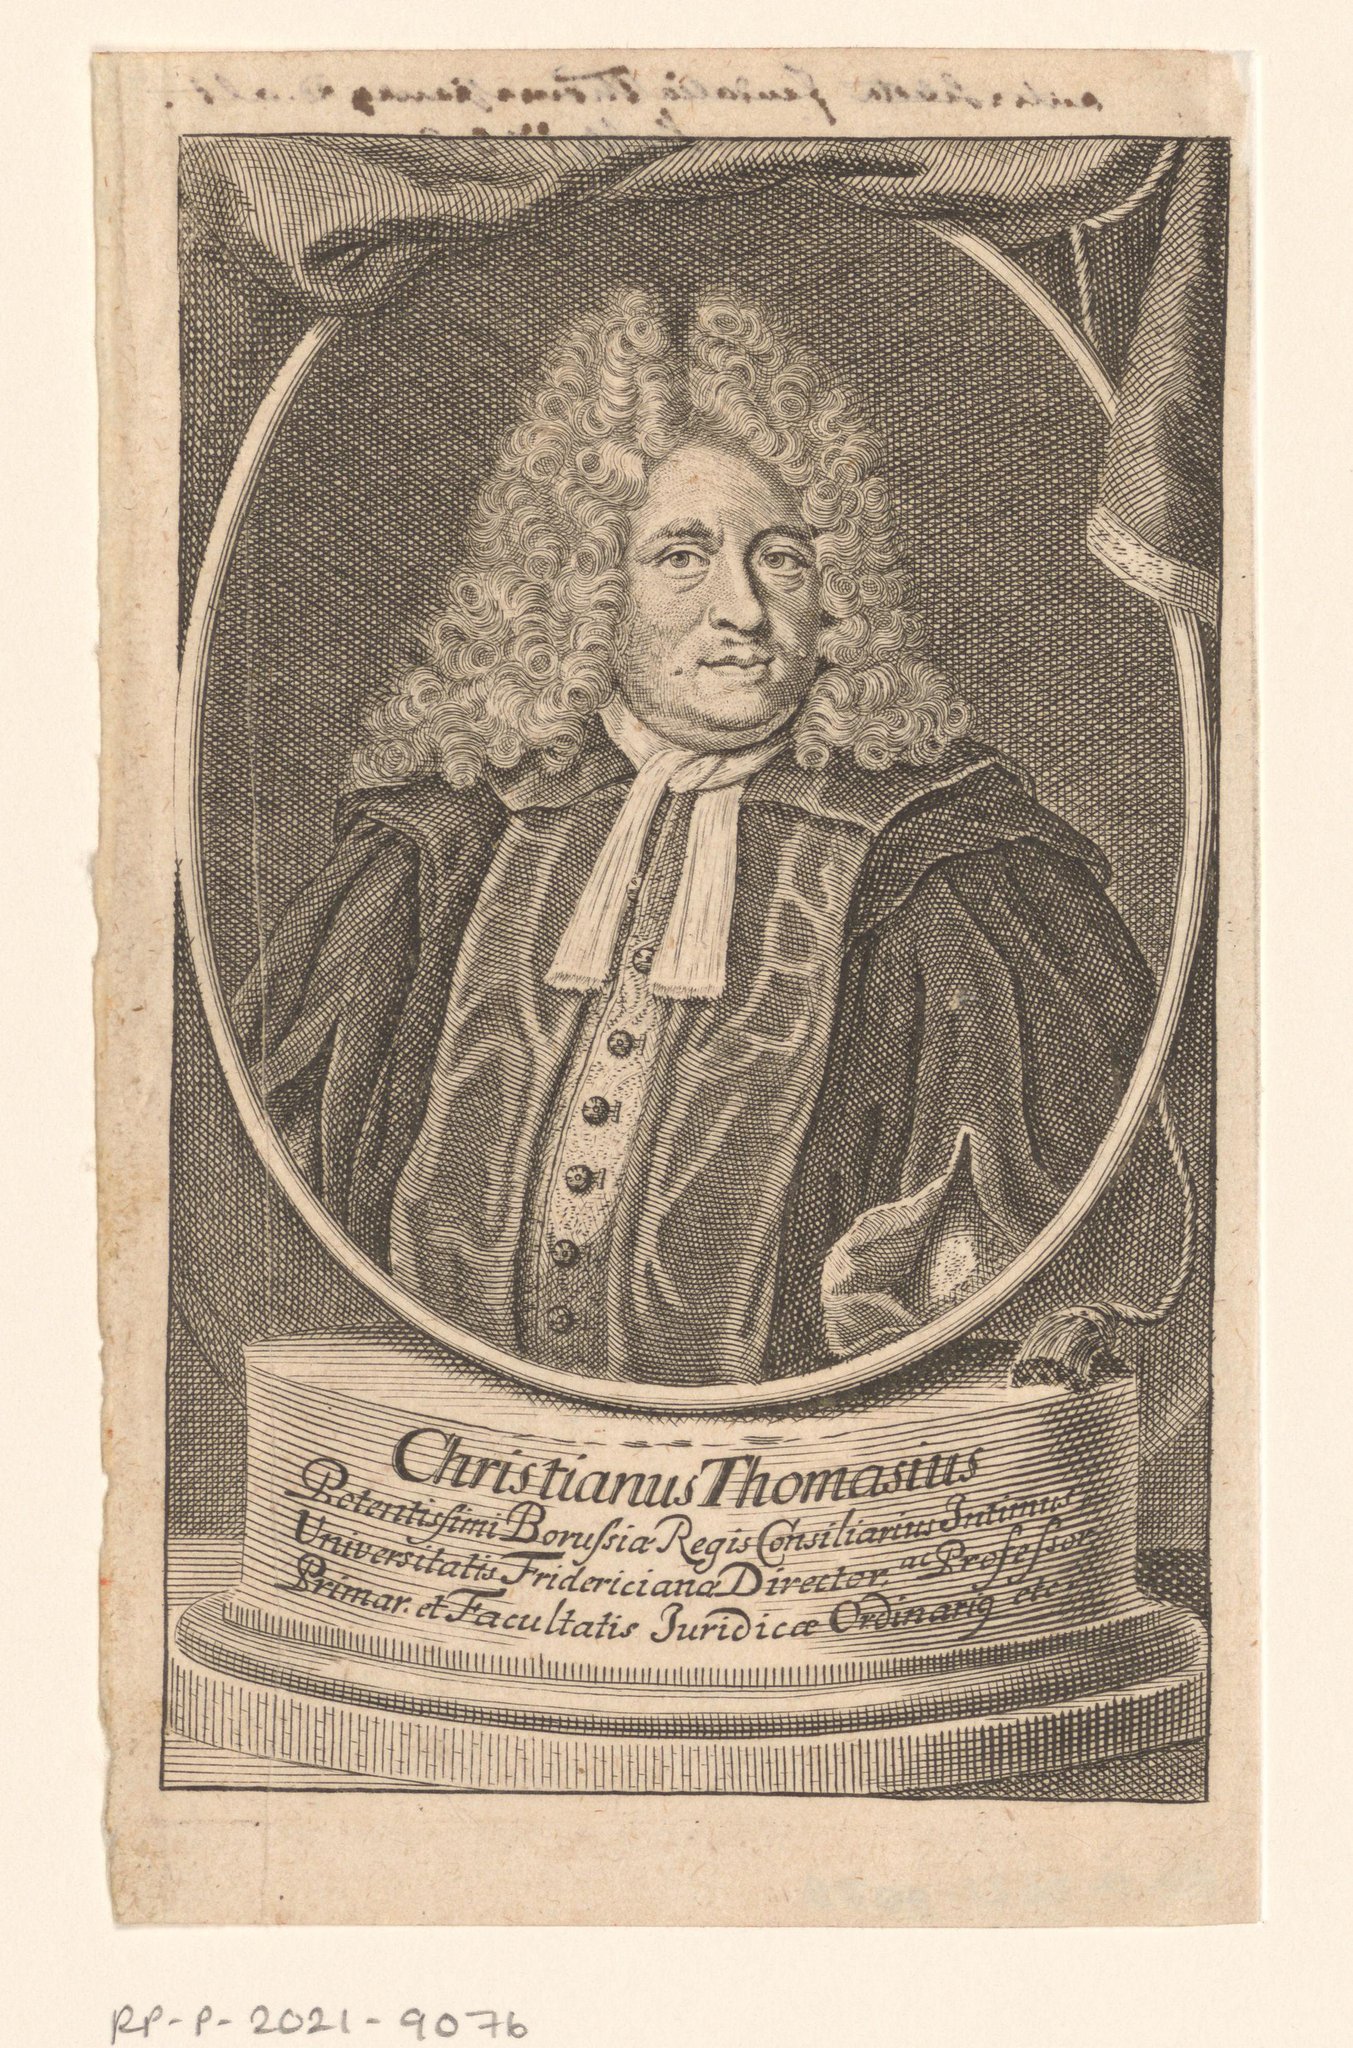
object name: print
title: Portret van Christian Thomasius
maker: martin bernigeroth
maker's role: print maker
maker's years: 1670-1733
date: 1694-1733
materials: paper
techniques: engraving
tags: christian thomasius, scholar, philosopher, historical persons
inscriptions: inscription: ‘[...]/Halle[?] 1738’